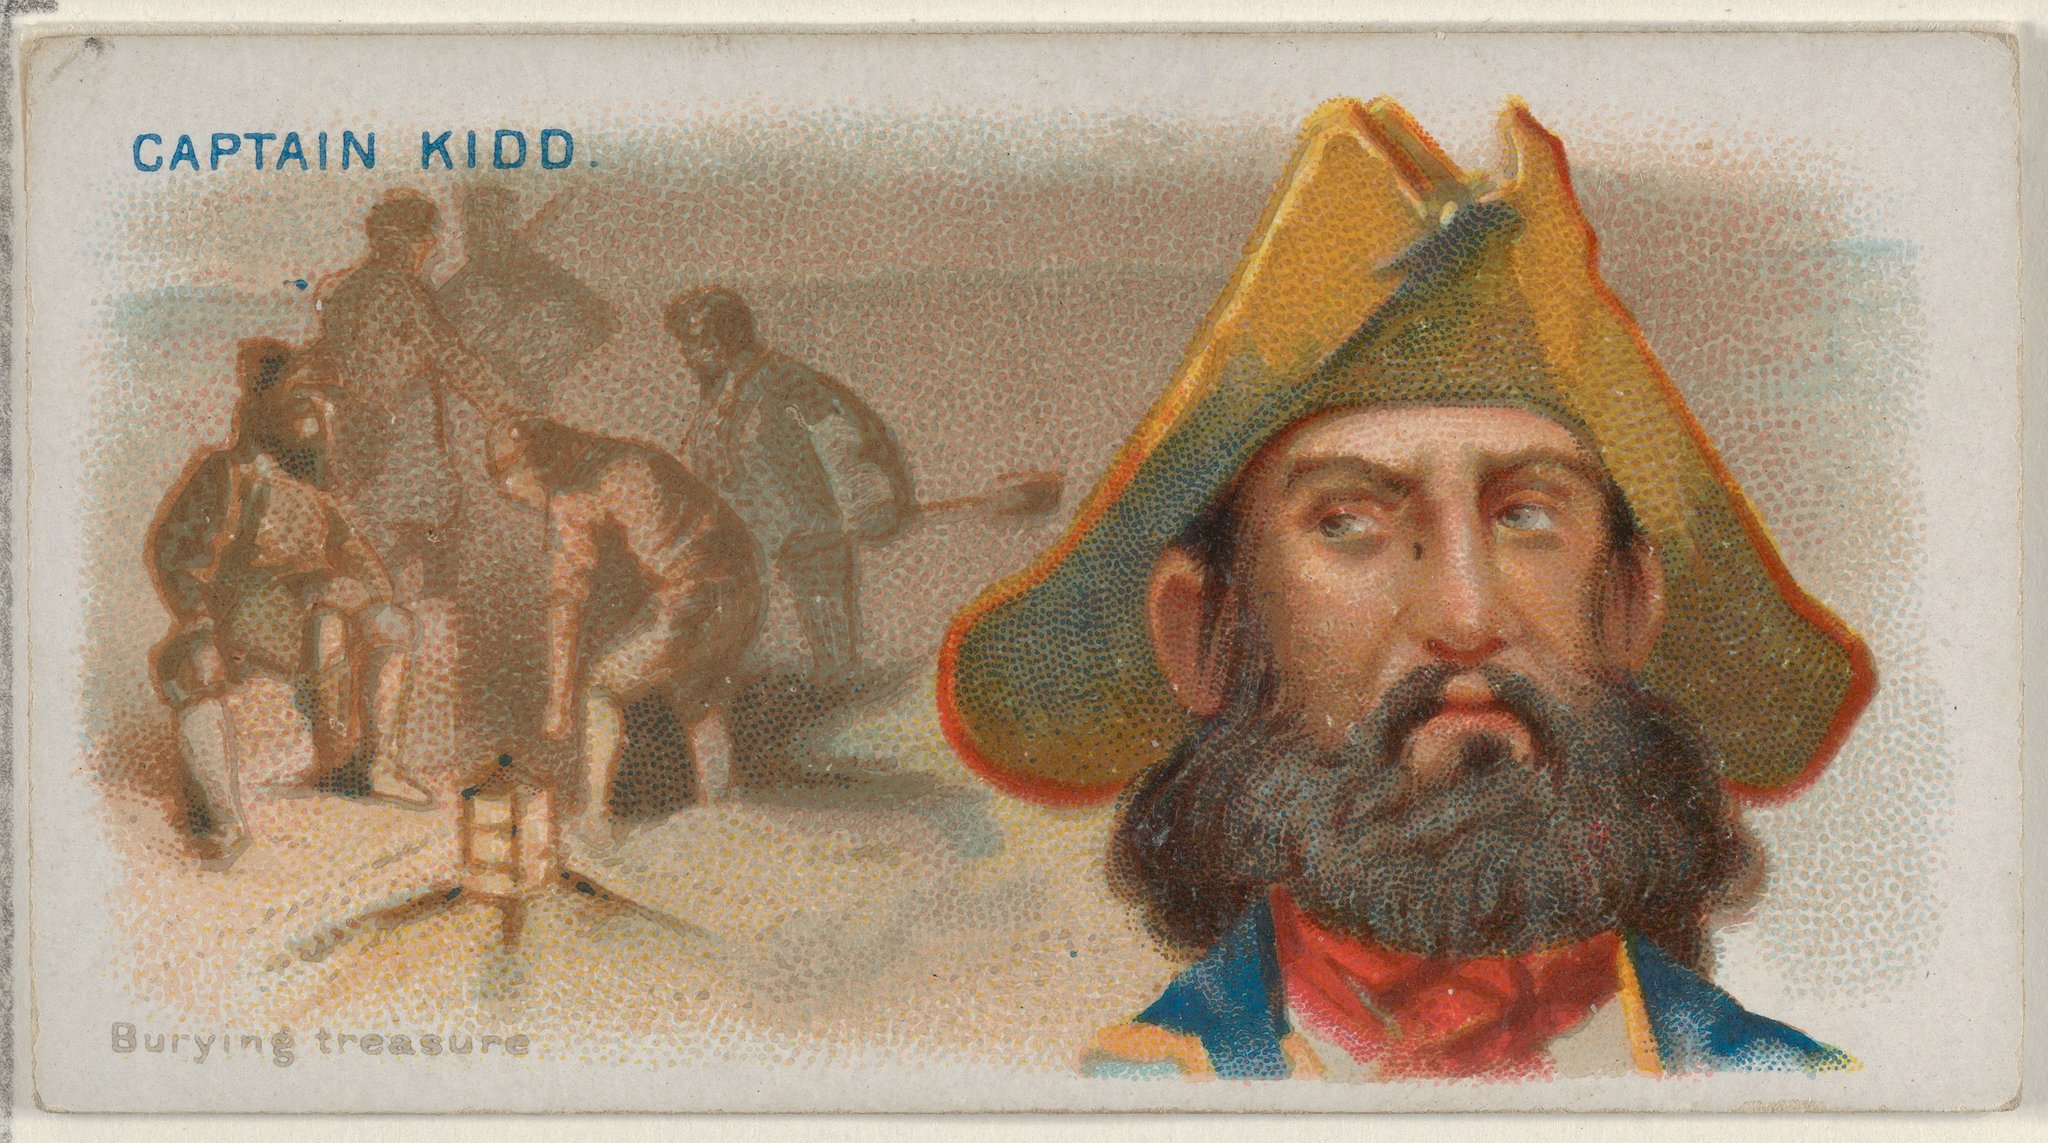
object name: print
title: Captain Kidd, Burying Treasure, from the Pirates of the Spanish Main series (N19) for Allen & Ginter Cigarettes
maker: allen & ginter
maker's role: publisher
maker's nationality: american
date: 1888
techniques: color lithograph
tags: men